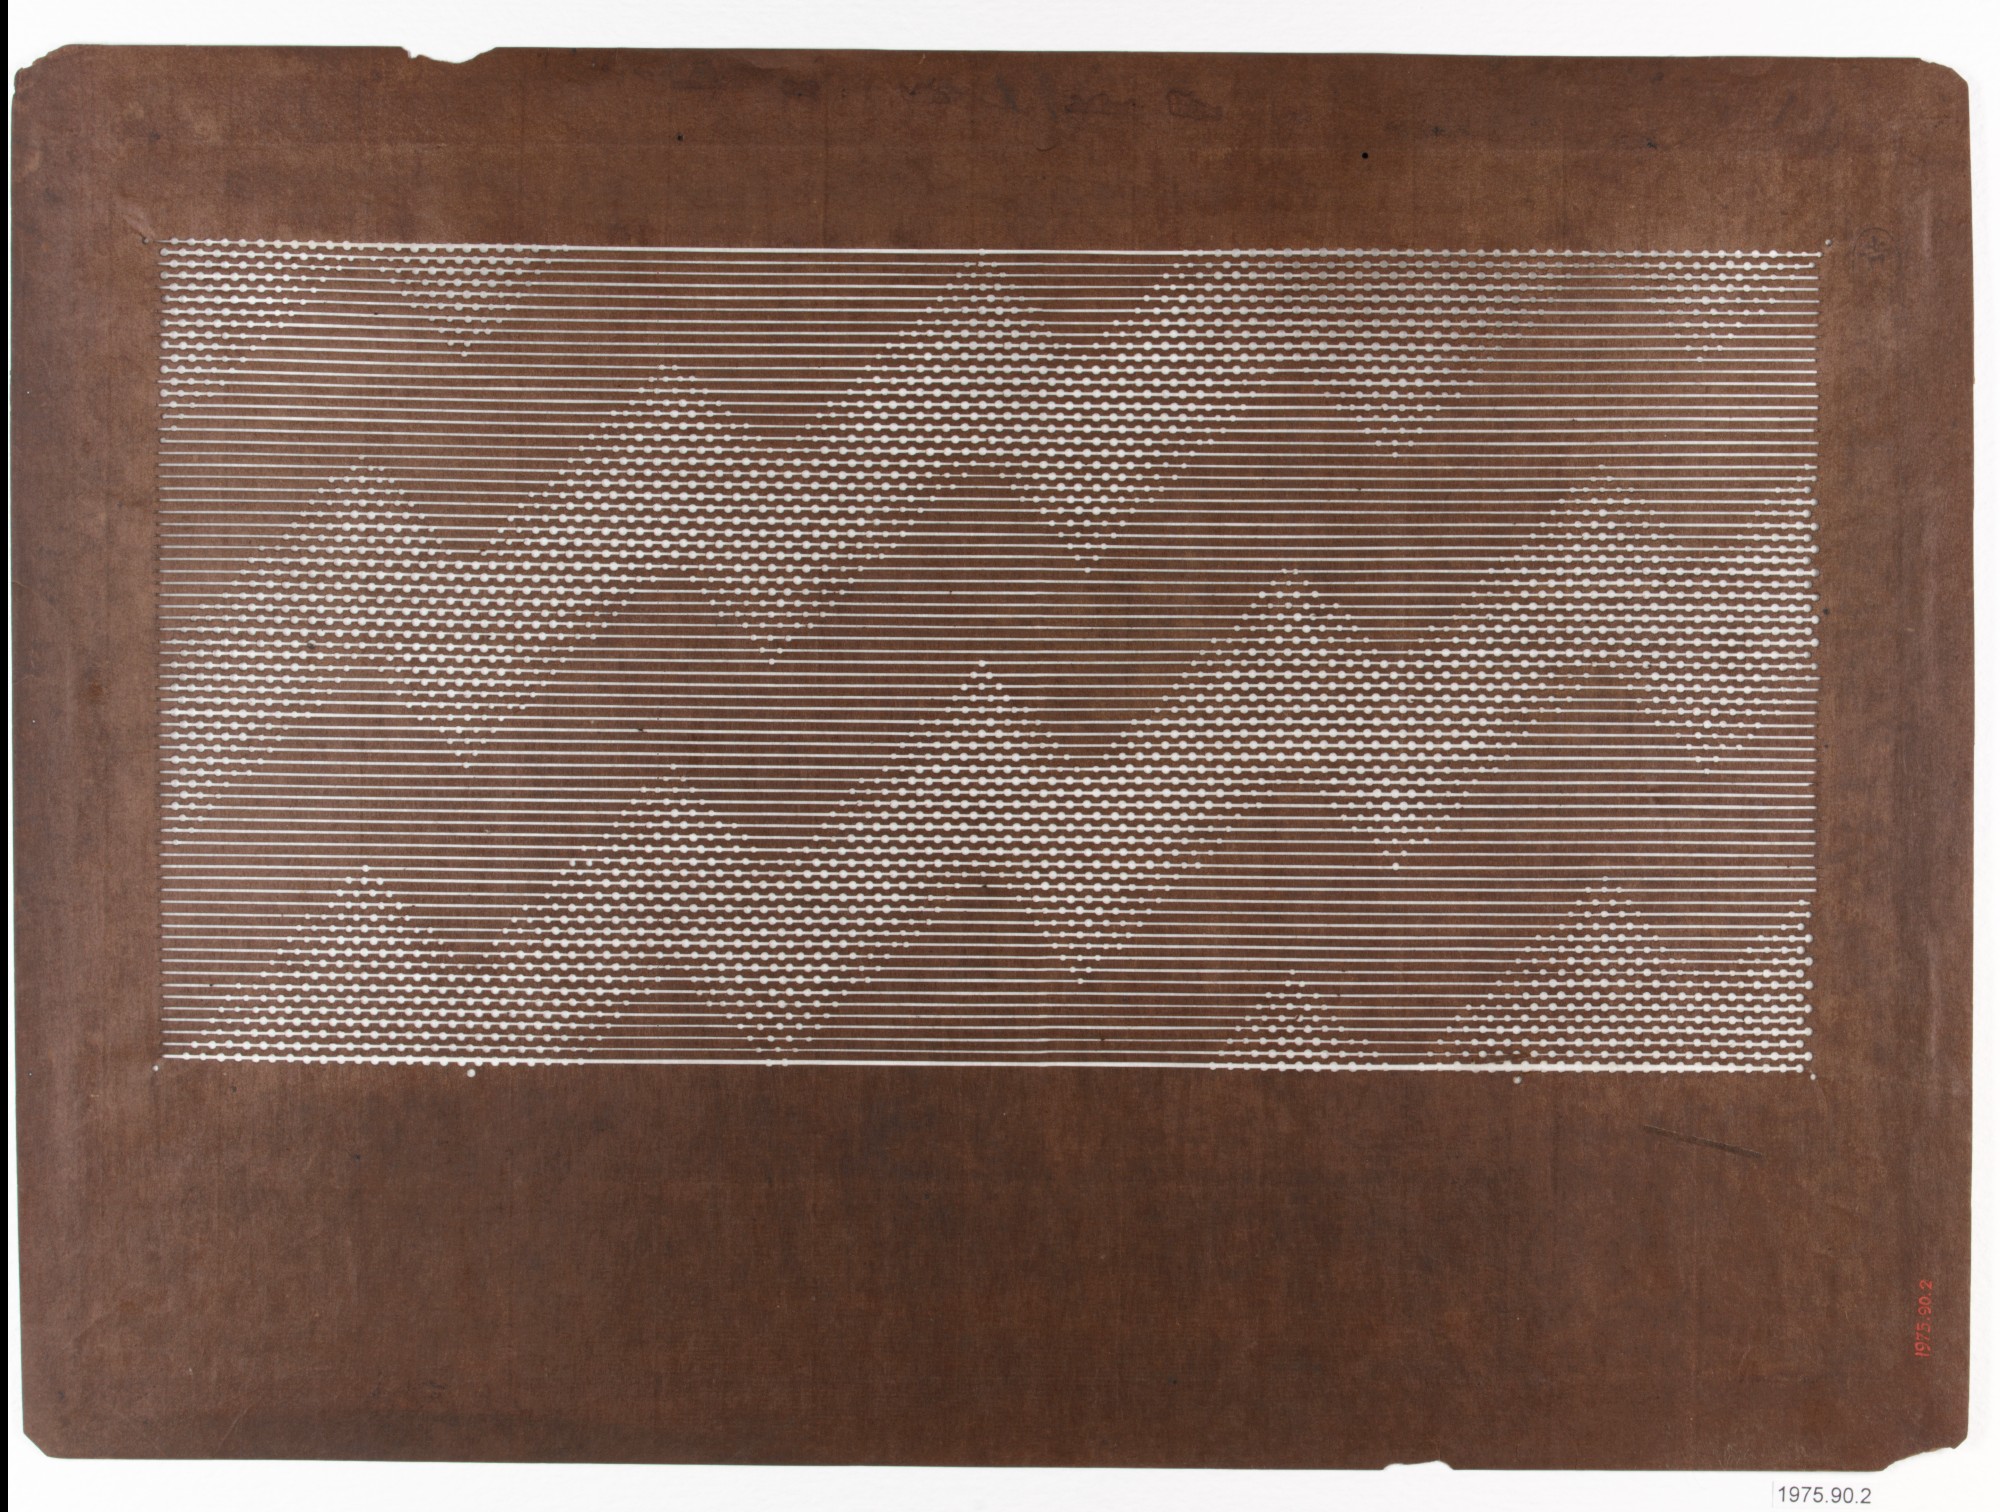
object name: stencil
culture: japanese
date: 1867-1933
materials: paper, silk